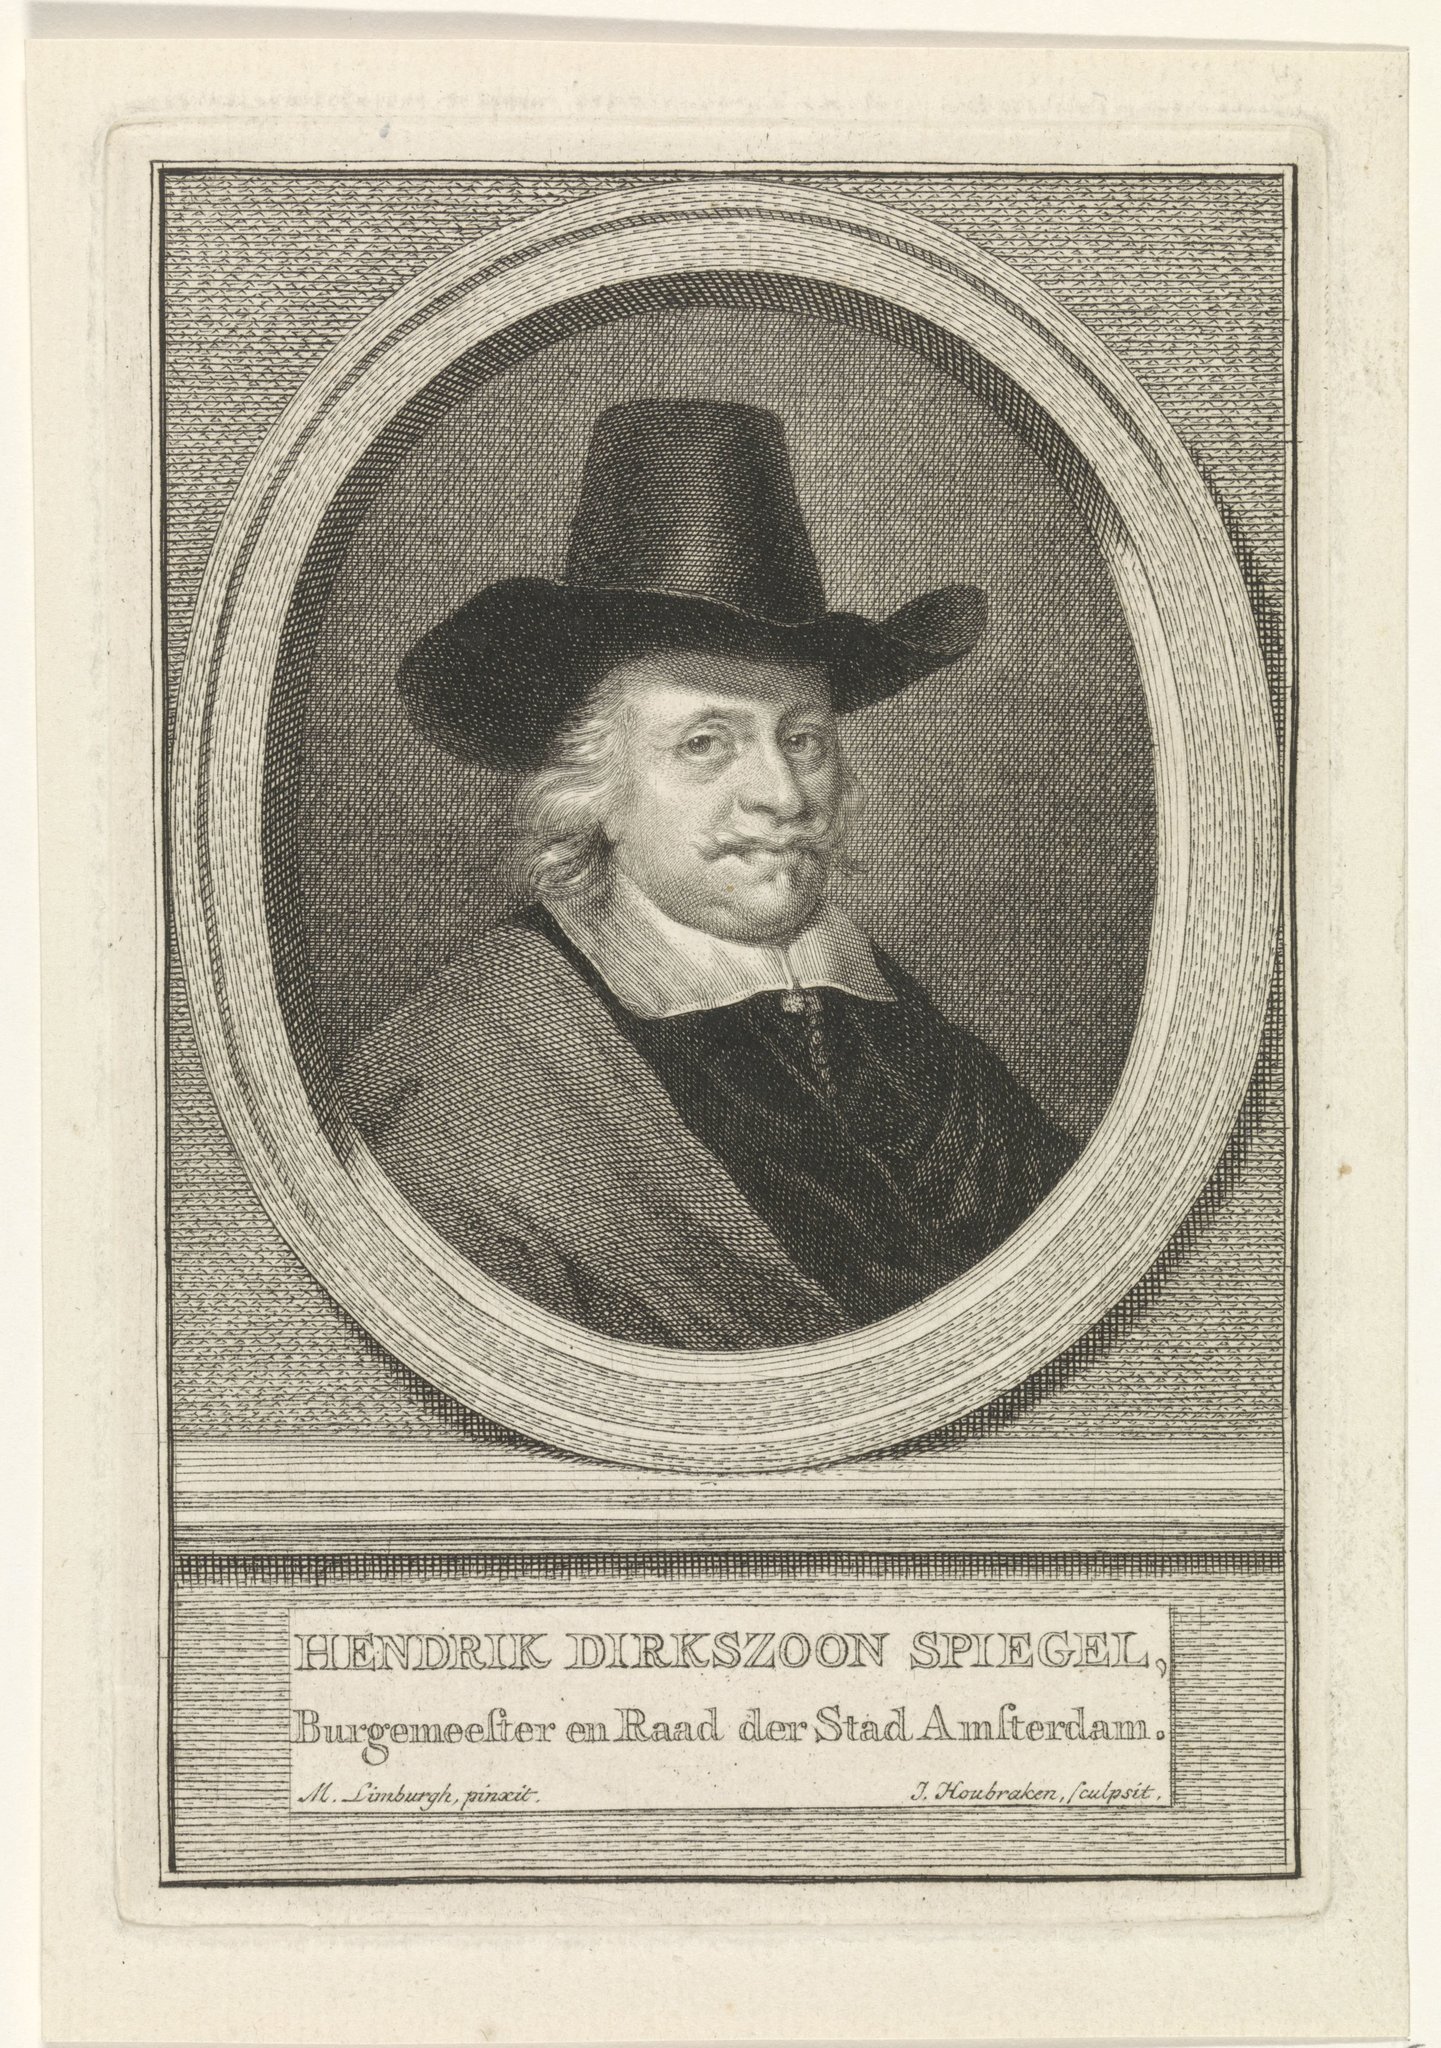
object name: print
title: Portret van Hendrick Dircksz. Spiegel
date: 1749-1796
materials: paper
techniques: engraving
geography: amsterdam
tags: hendrick dircksz. spiegel, historical persons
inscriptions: collector's mark: Lugt 2165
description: Latere staat van deze prent is oorspronkelijk bedoeld als aanvulling op Jan Wagenaars ‘Vaderlandsche historie’* en was zo vanaf 1796 verkrijgbaar bij Johannes Allart te Amsterdam. Voor de advertentie waarin Allart de 60 portretten en 7 platen, allen gegraveerd door Houbraken, ter aanvulling op Wagenaars ‘Vaderlandsche historie’ aanbiedt, zie RP-P-OB-77.766. *Van dit werk zijn in de achttiende eeuw meerdere uitgaves verschenen, zoals: Wagenaar, Jan. Vaderlandsche historie, vervattende de geschiedenissen der Vereenigde Nederlanden (…). 21 delen. Amsterdam: Isaak Tirion, 1749-1759. Wagenaar, Jan. Vaderlandsche historie, vervattende de geschiedenissen der nu Vereenigde Nederlanden (…). 21 delen. Amsterdam: weduwe Isaak Tirion, 1770. Wagenaar, Jan. Vaderlandsche historie, vervattende de geschiedenissen der nu Vereenigde Nederlanden (…). 21 delen. Amsterdam, Leiden, Dordrecht en Harlingen: P. Schouten e.a., 1782. Wagenaar, Jan. Vaderlandsche historie, vervattende de geschiedenissen der nu Vereenigde Nederlanden (…). 21 delen. Amsterdam: Johannes Allart, 1790-1796.